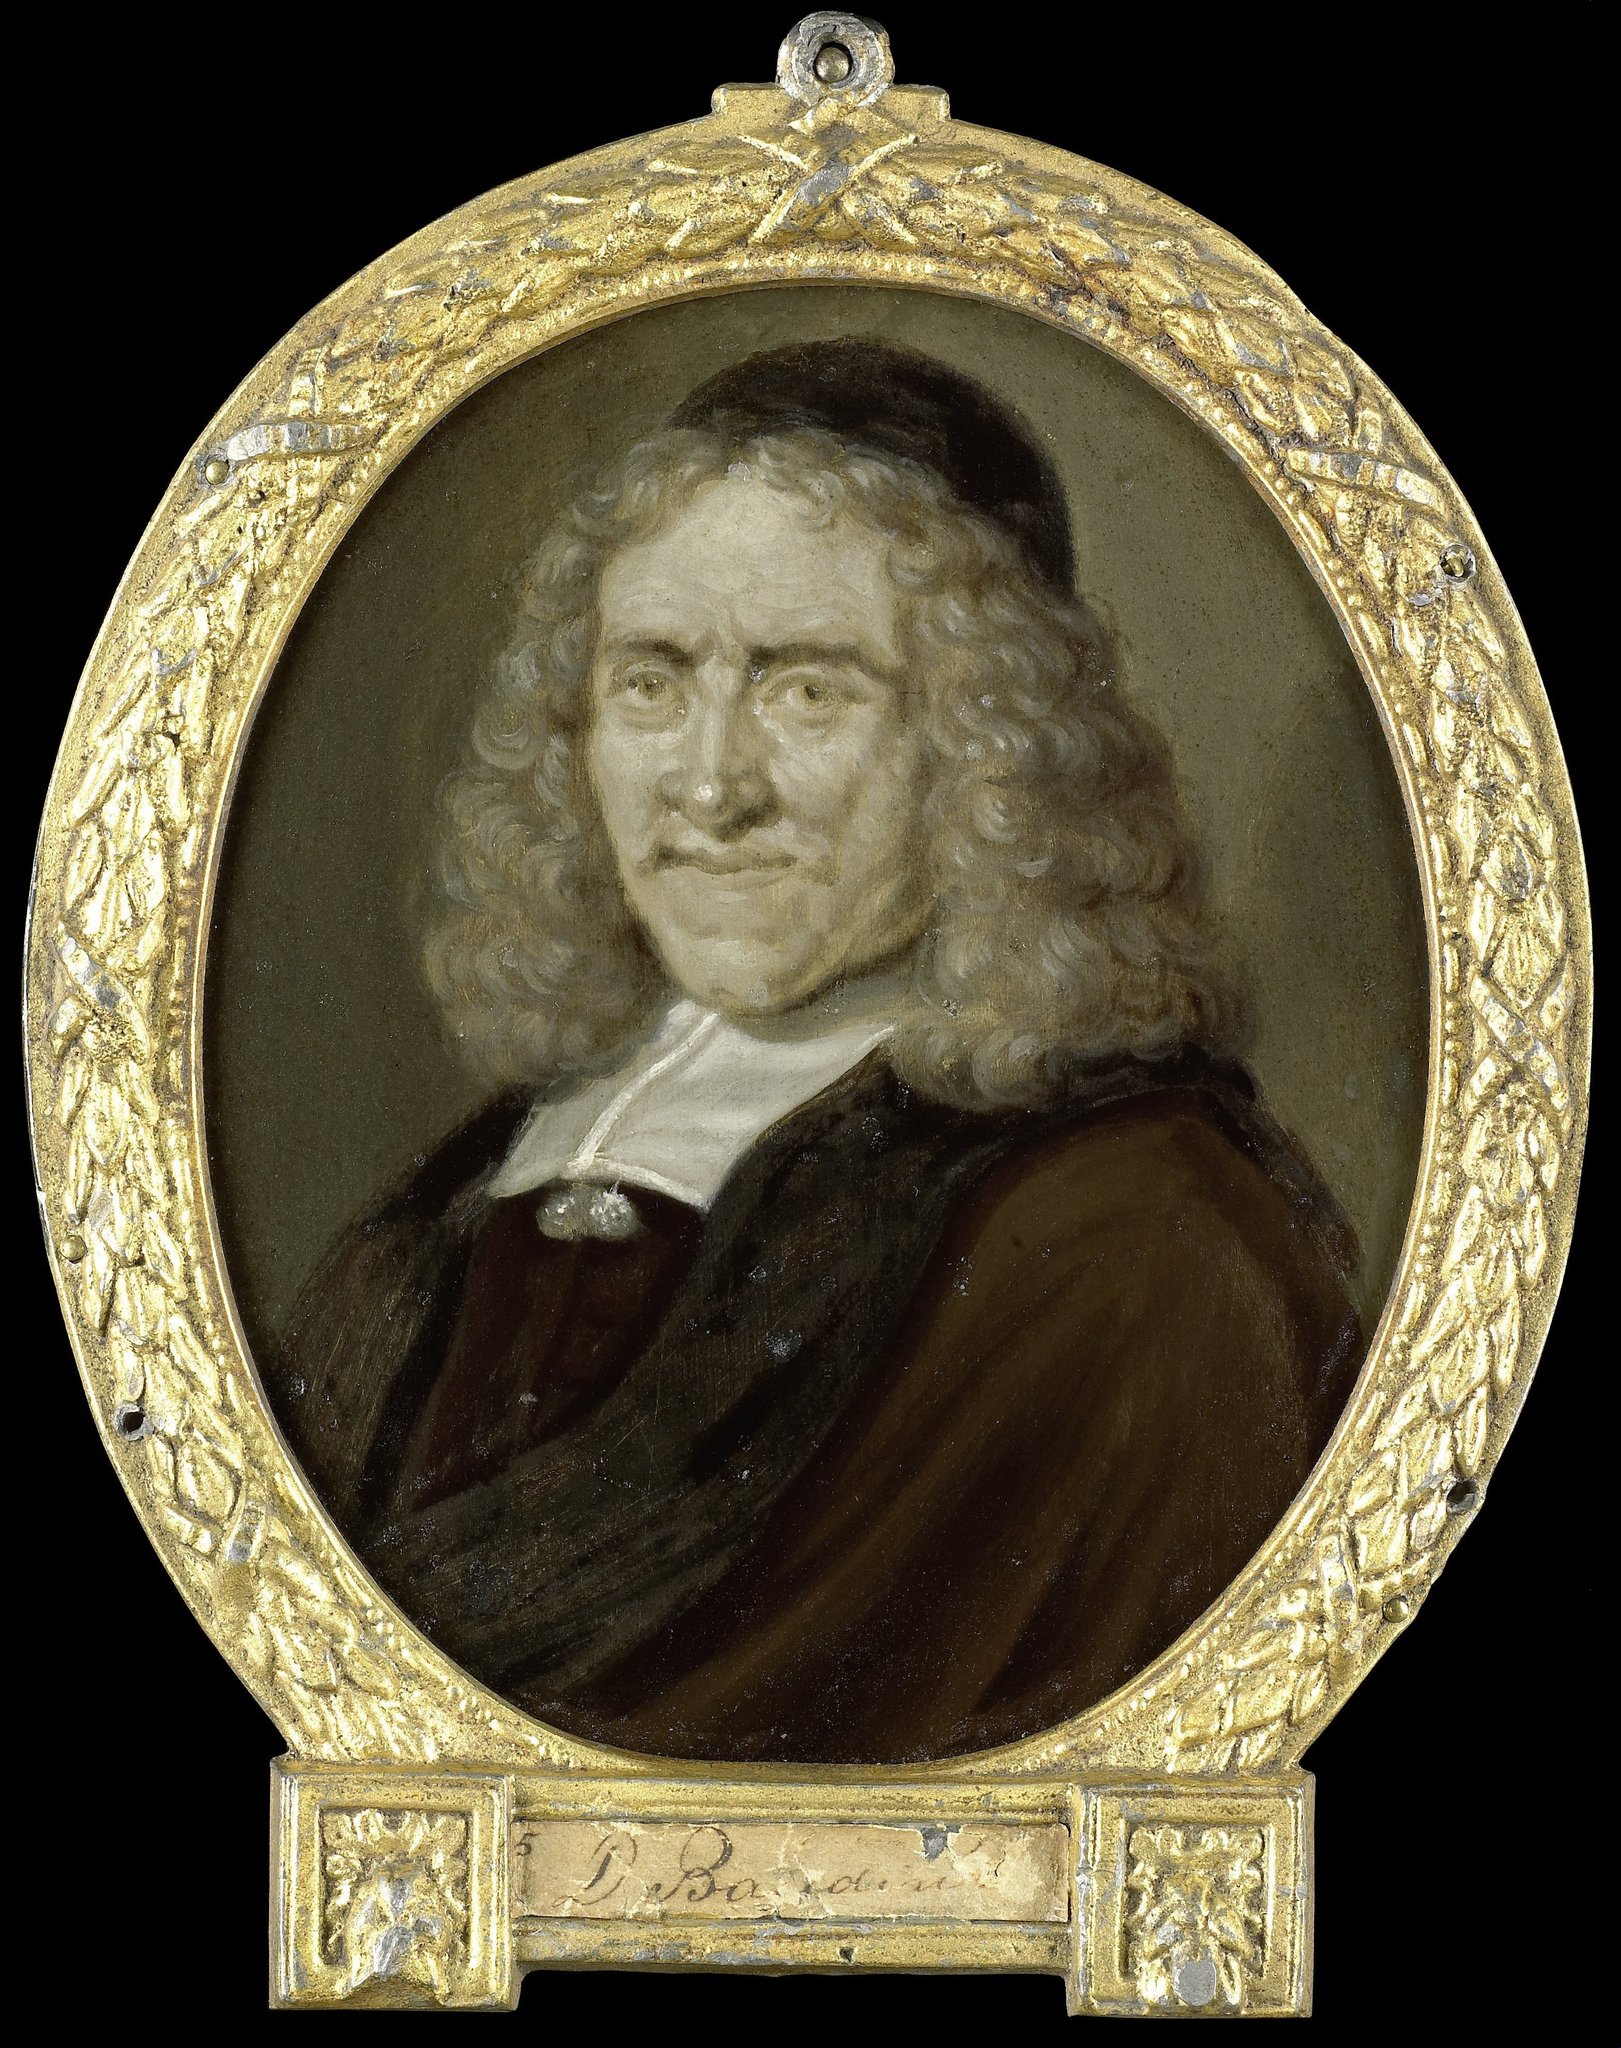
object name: painting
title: Portrait of Willem Jacobsz van Heemskerck, Poet and Engraver on Glass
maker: arnoud van halen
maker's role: draughtsman, painter, print maker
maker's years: 1673-1732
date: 1700-1732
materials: oil, metal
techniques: grisaille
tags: leiden, willem jacobszoon van heemskerck, portrait of a writer, writer, poet, author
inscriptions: inscription: ‘Wilh. Heemskerk 1613’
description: Portret van Willem Jacobszoon van Heemskerck (1613-92). Dichter en glasetser. Buste in ovaal, naar links. Onderdeel van een verzameling portretten van Nederlandse dichters.